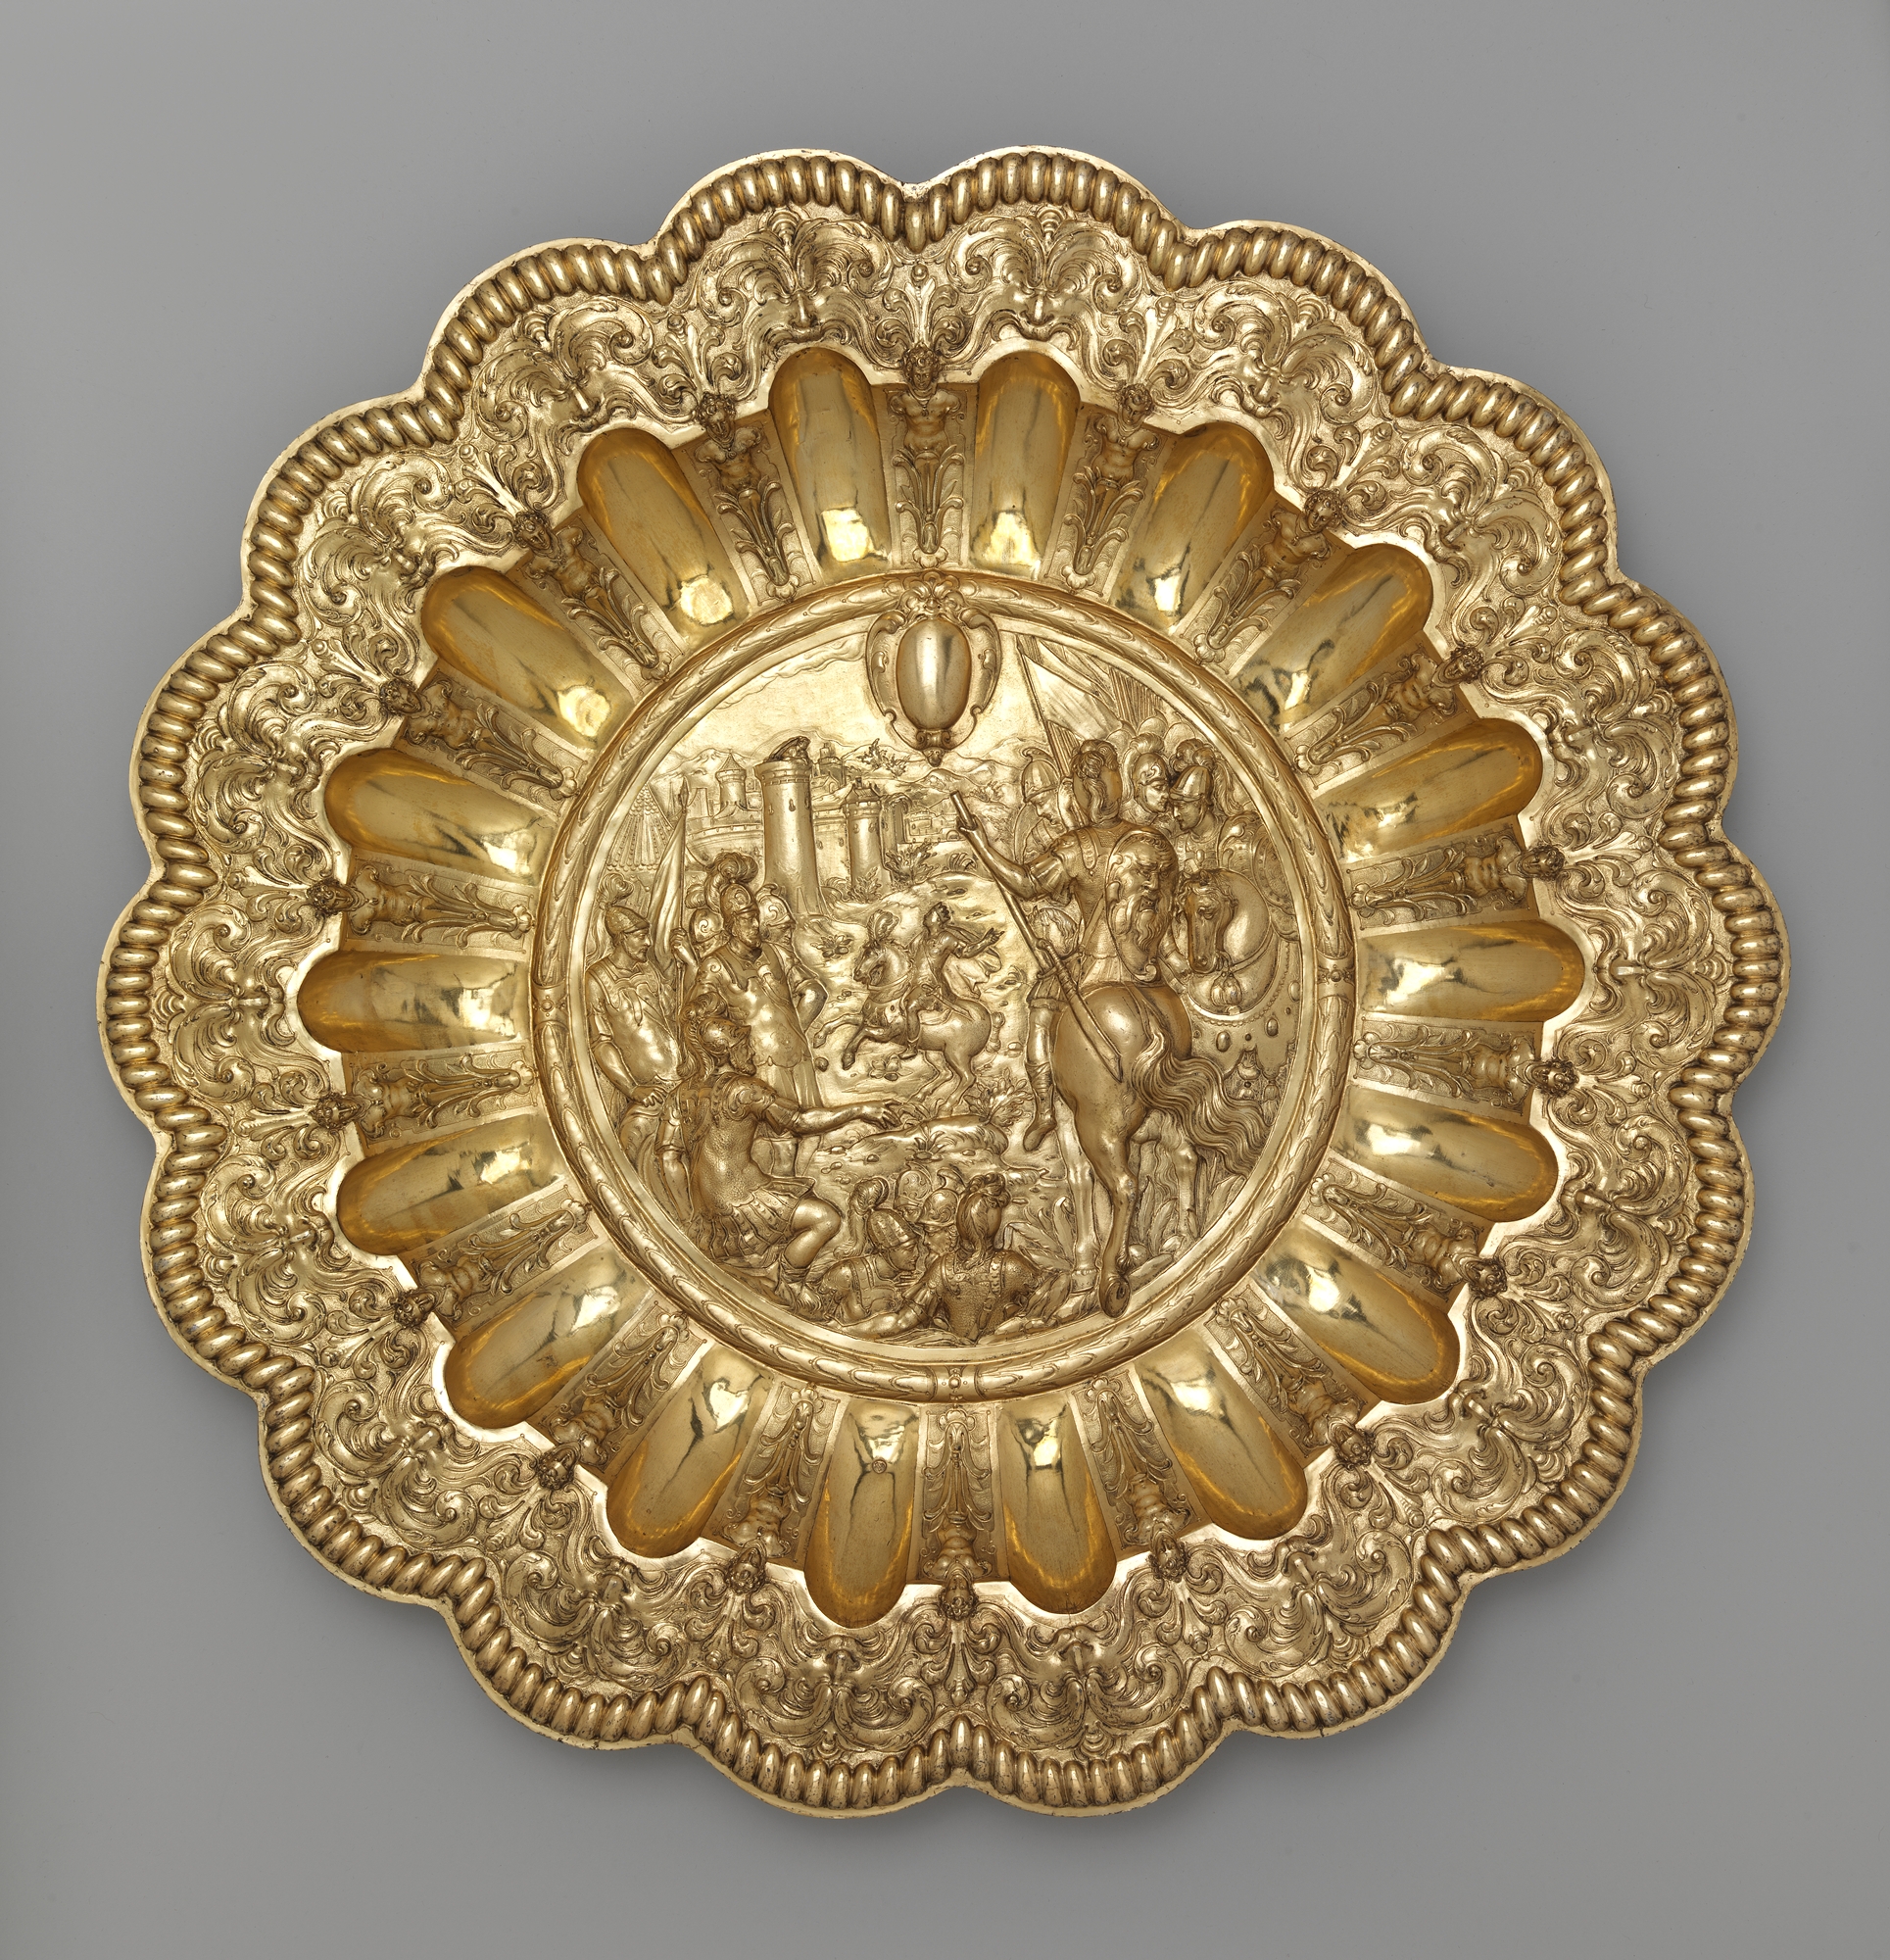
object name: basin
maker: elkington & co.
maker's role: manufacturer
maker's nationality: british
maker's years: 1829-1963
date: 1801-1900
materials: metal, silver gilt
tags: fortification,soldiers,horses